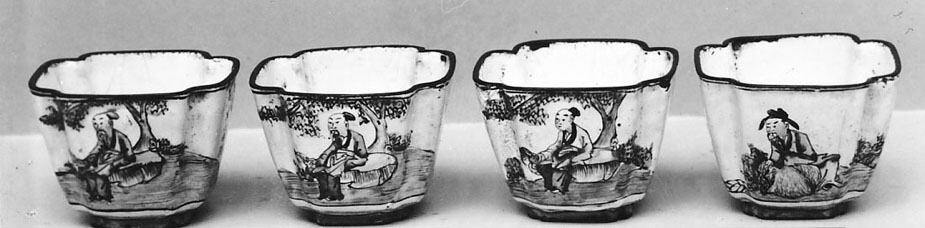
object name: cup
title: Square Cup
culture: chinese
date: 1736-1795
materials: enamel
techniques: painting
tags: men,trees